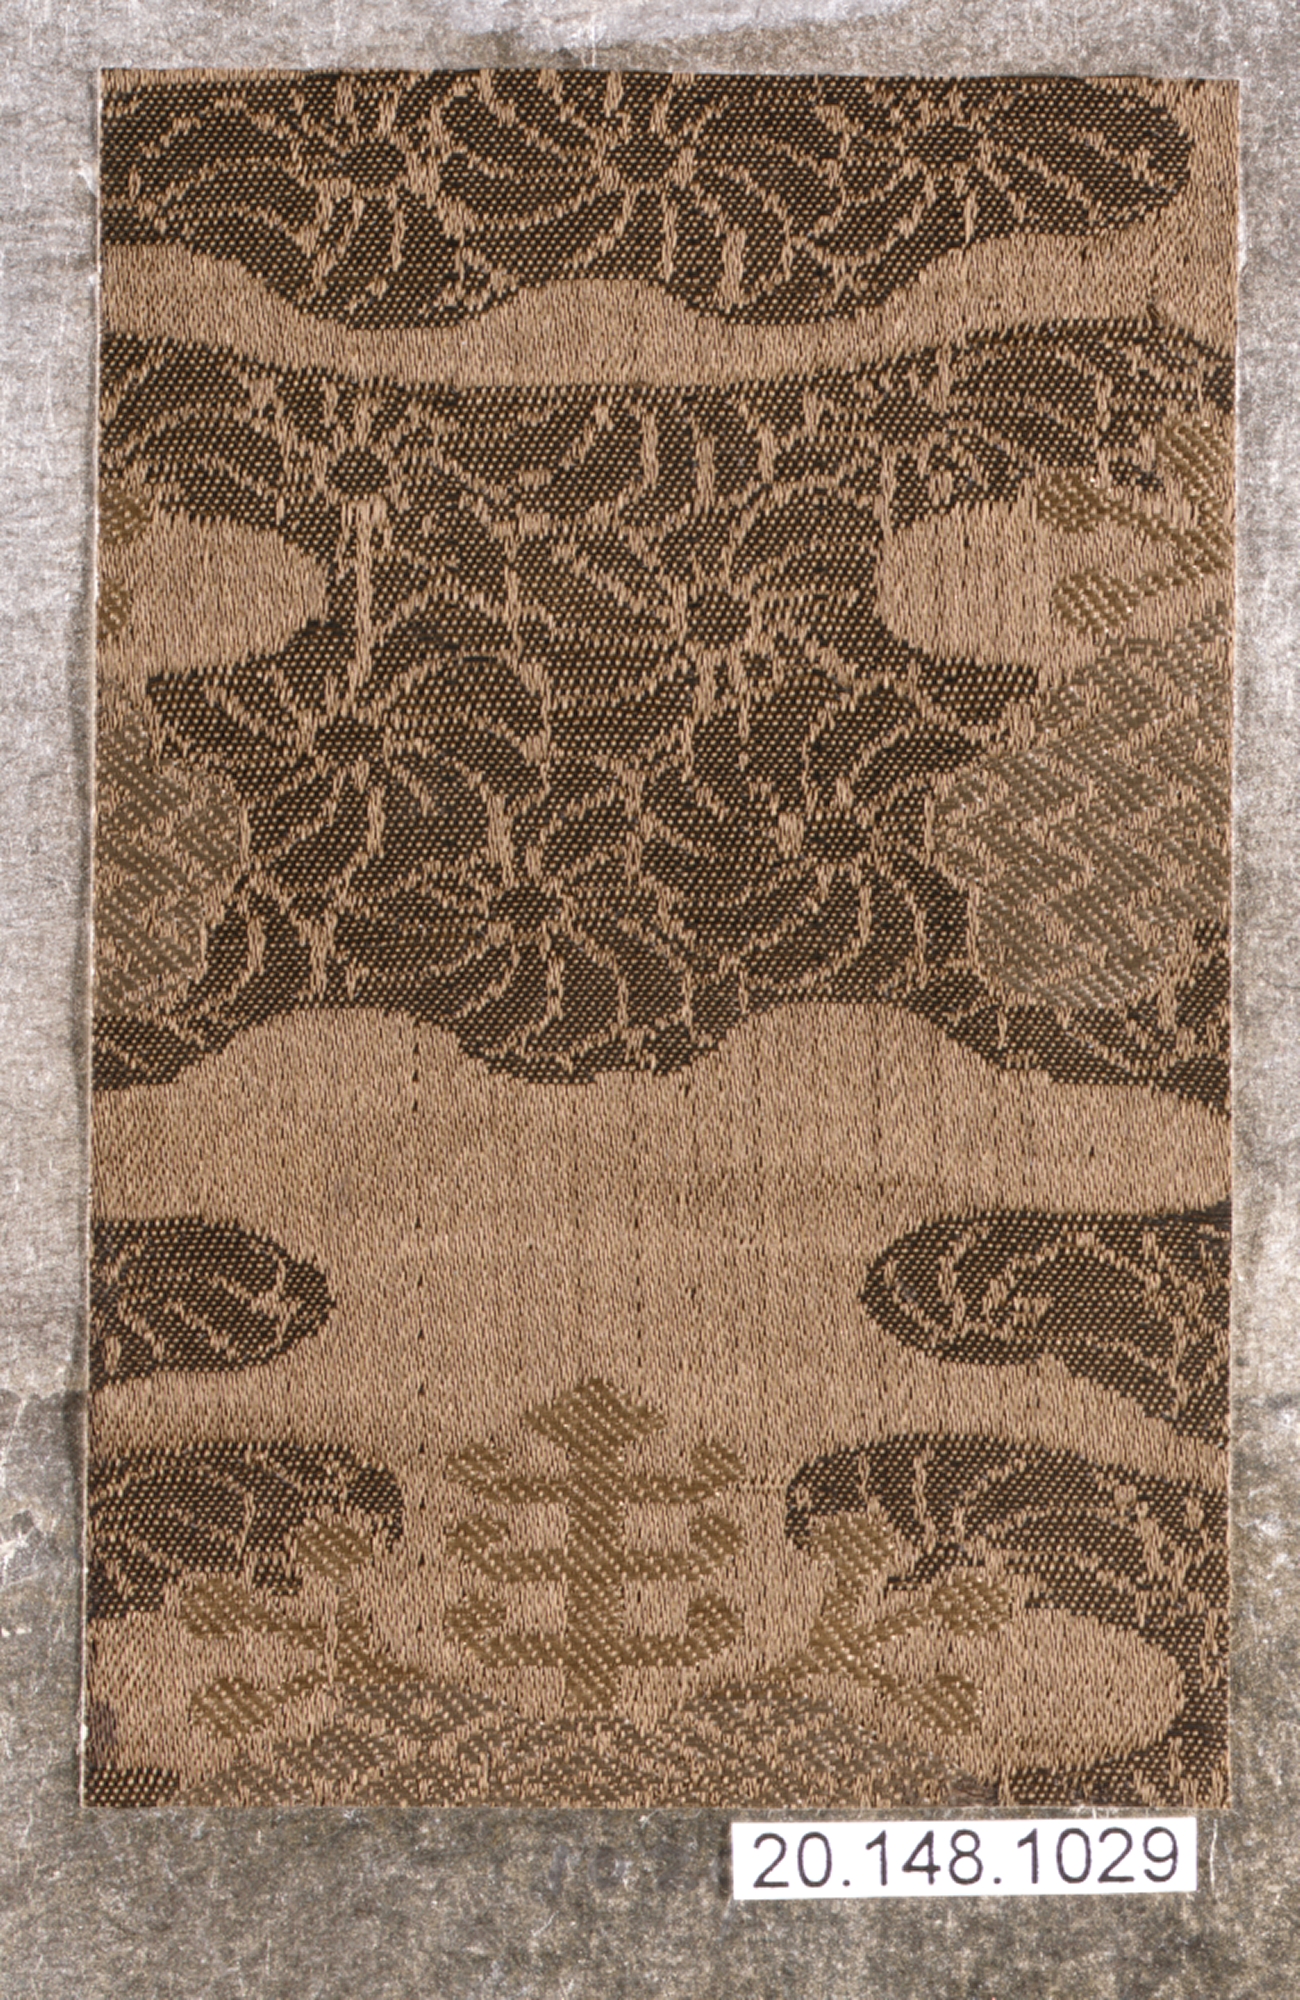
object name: piece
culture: japanese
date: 1701-1800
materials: silk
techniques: compound weave